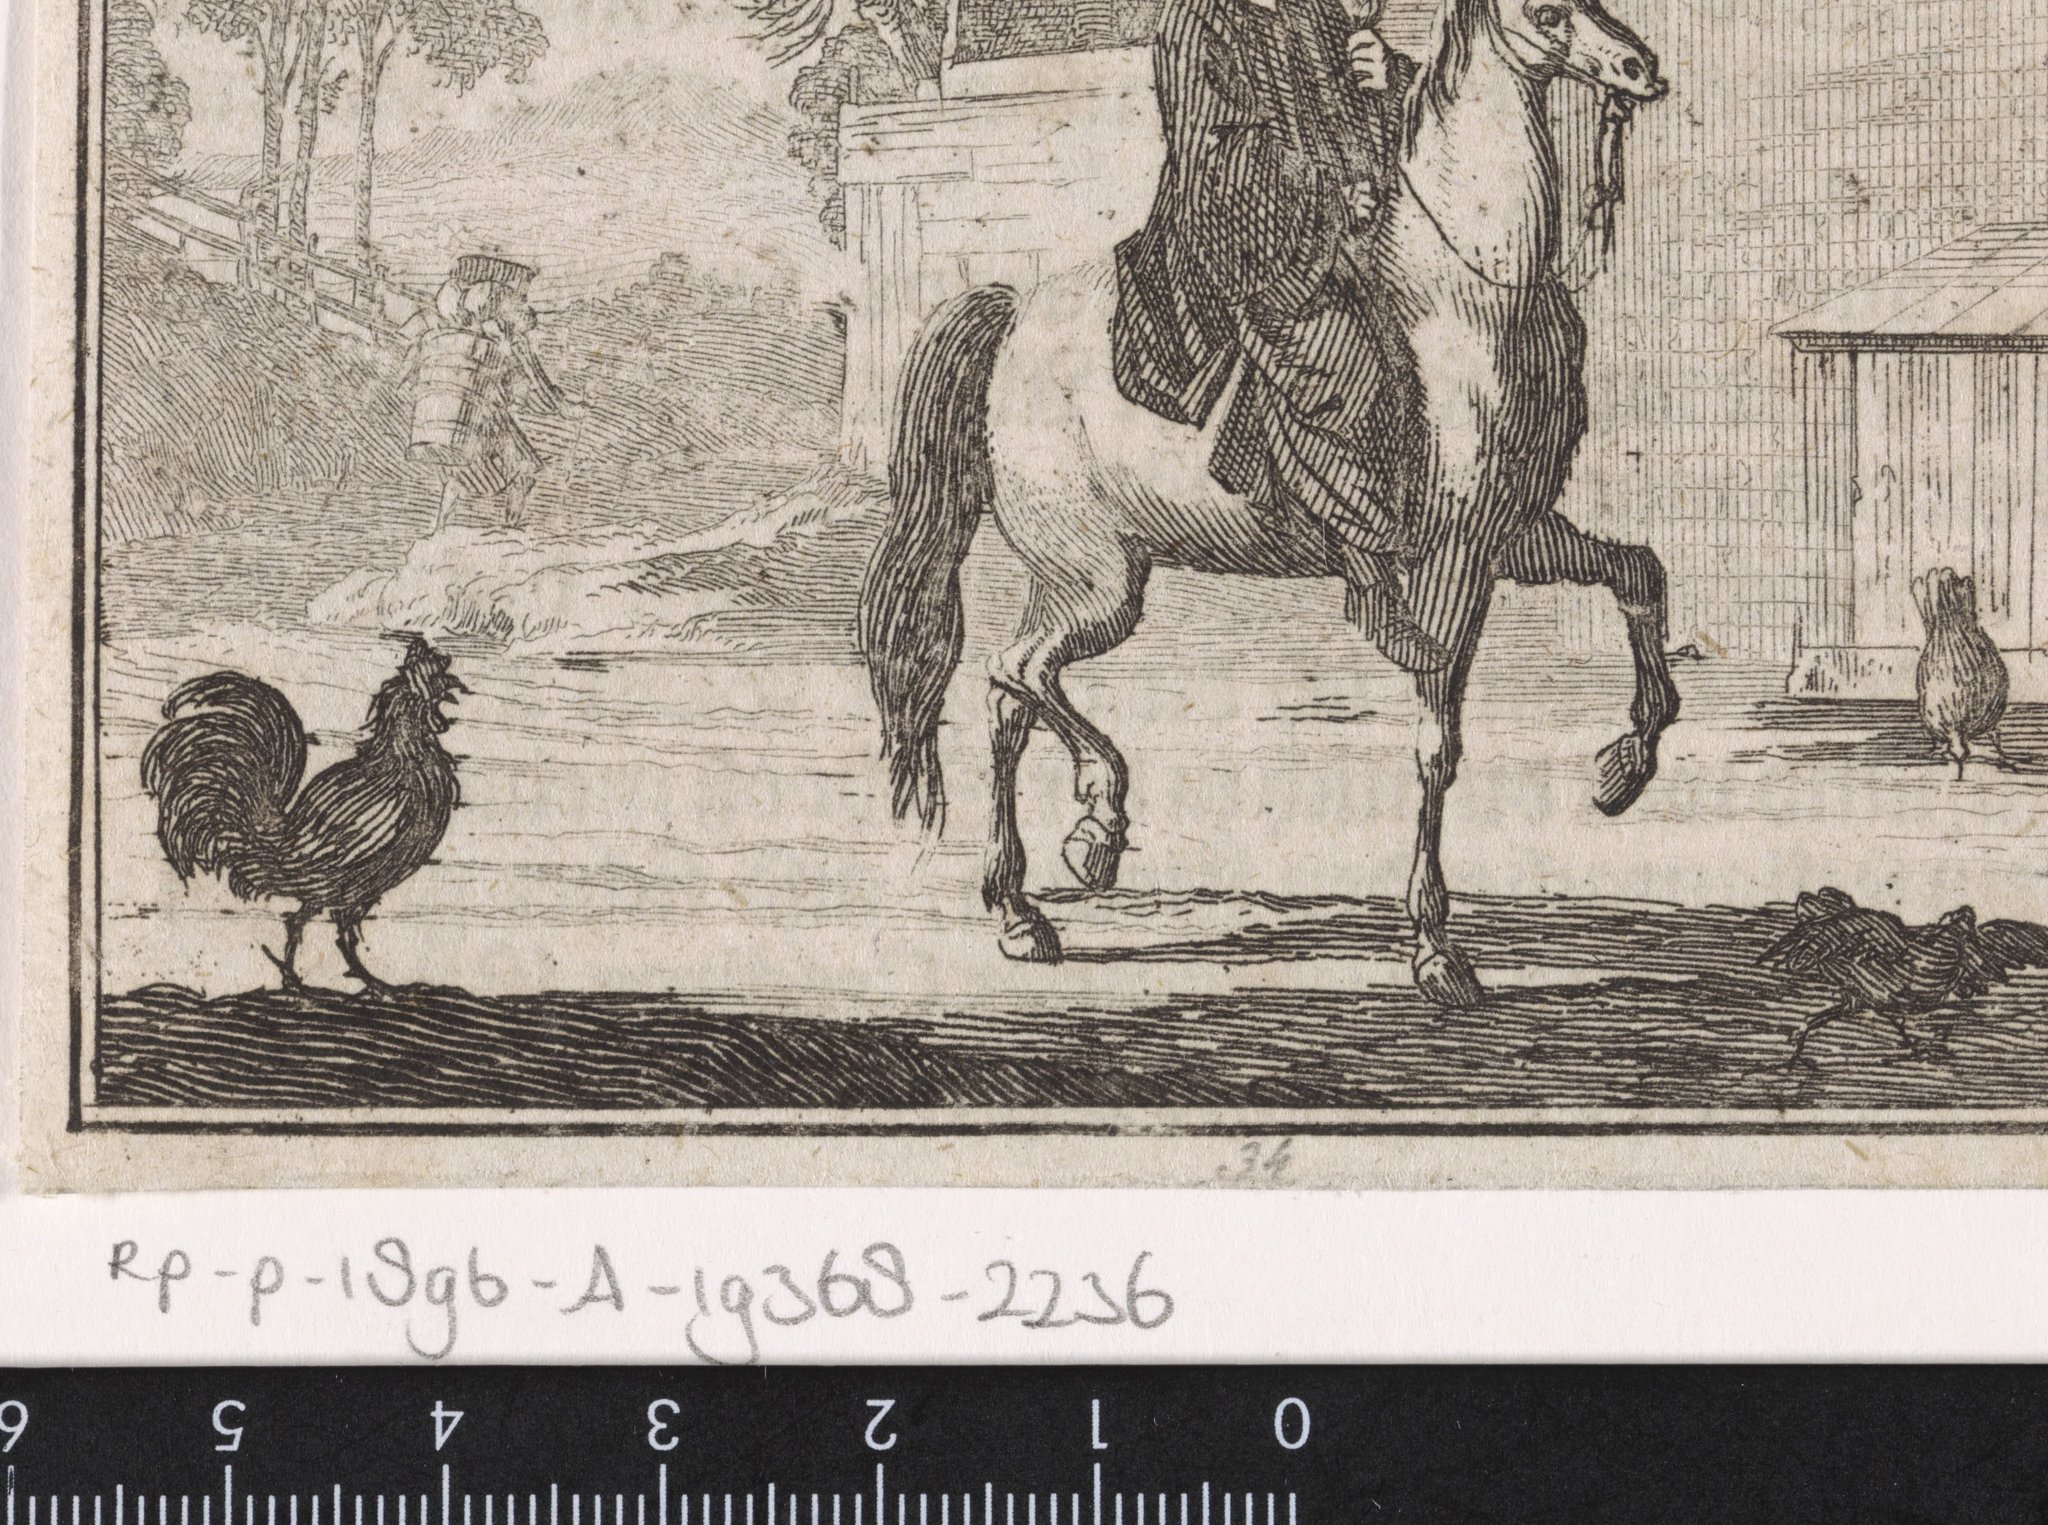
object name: book illustration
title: Lekenbroeder steelt een paard van een geestelijke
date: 1704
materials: paper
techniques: etching, letterpress printing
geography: nuremberg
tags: regular clerics, e.g. jesuits, redemptorists, thief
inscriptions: collector's mark: Lugt 2228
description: Illustratie uit: Abraham a Sancta Clara. Heilsames Gemisch Gemasch, das ist: Allerley seltsame und verwunderliche Geschichten (...). Neurenberg: Christoph Weigel, 1704, p. 316.